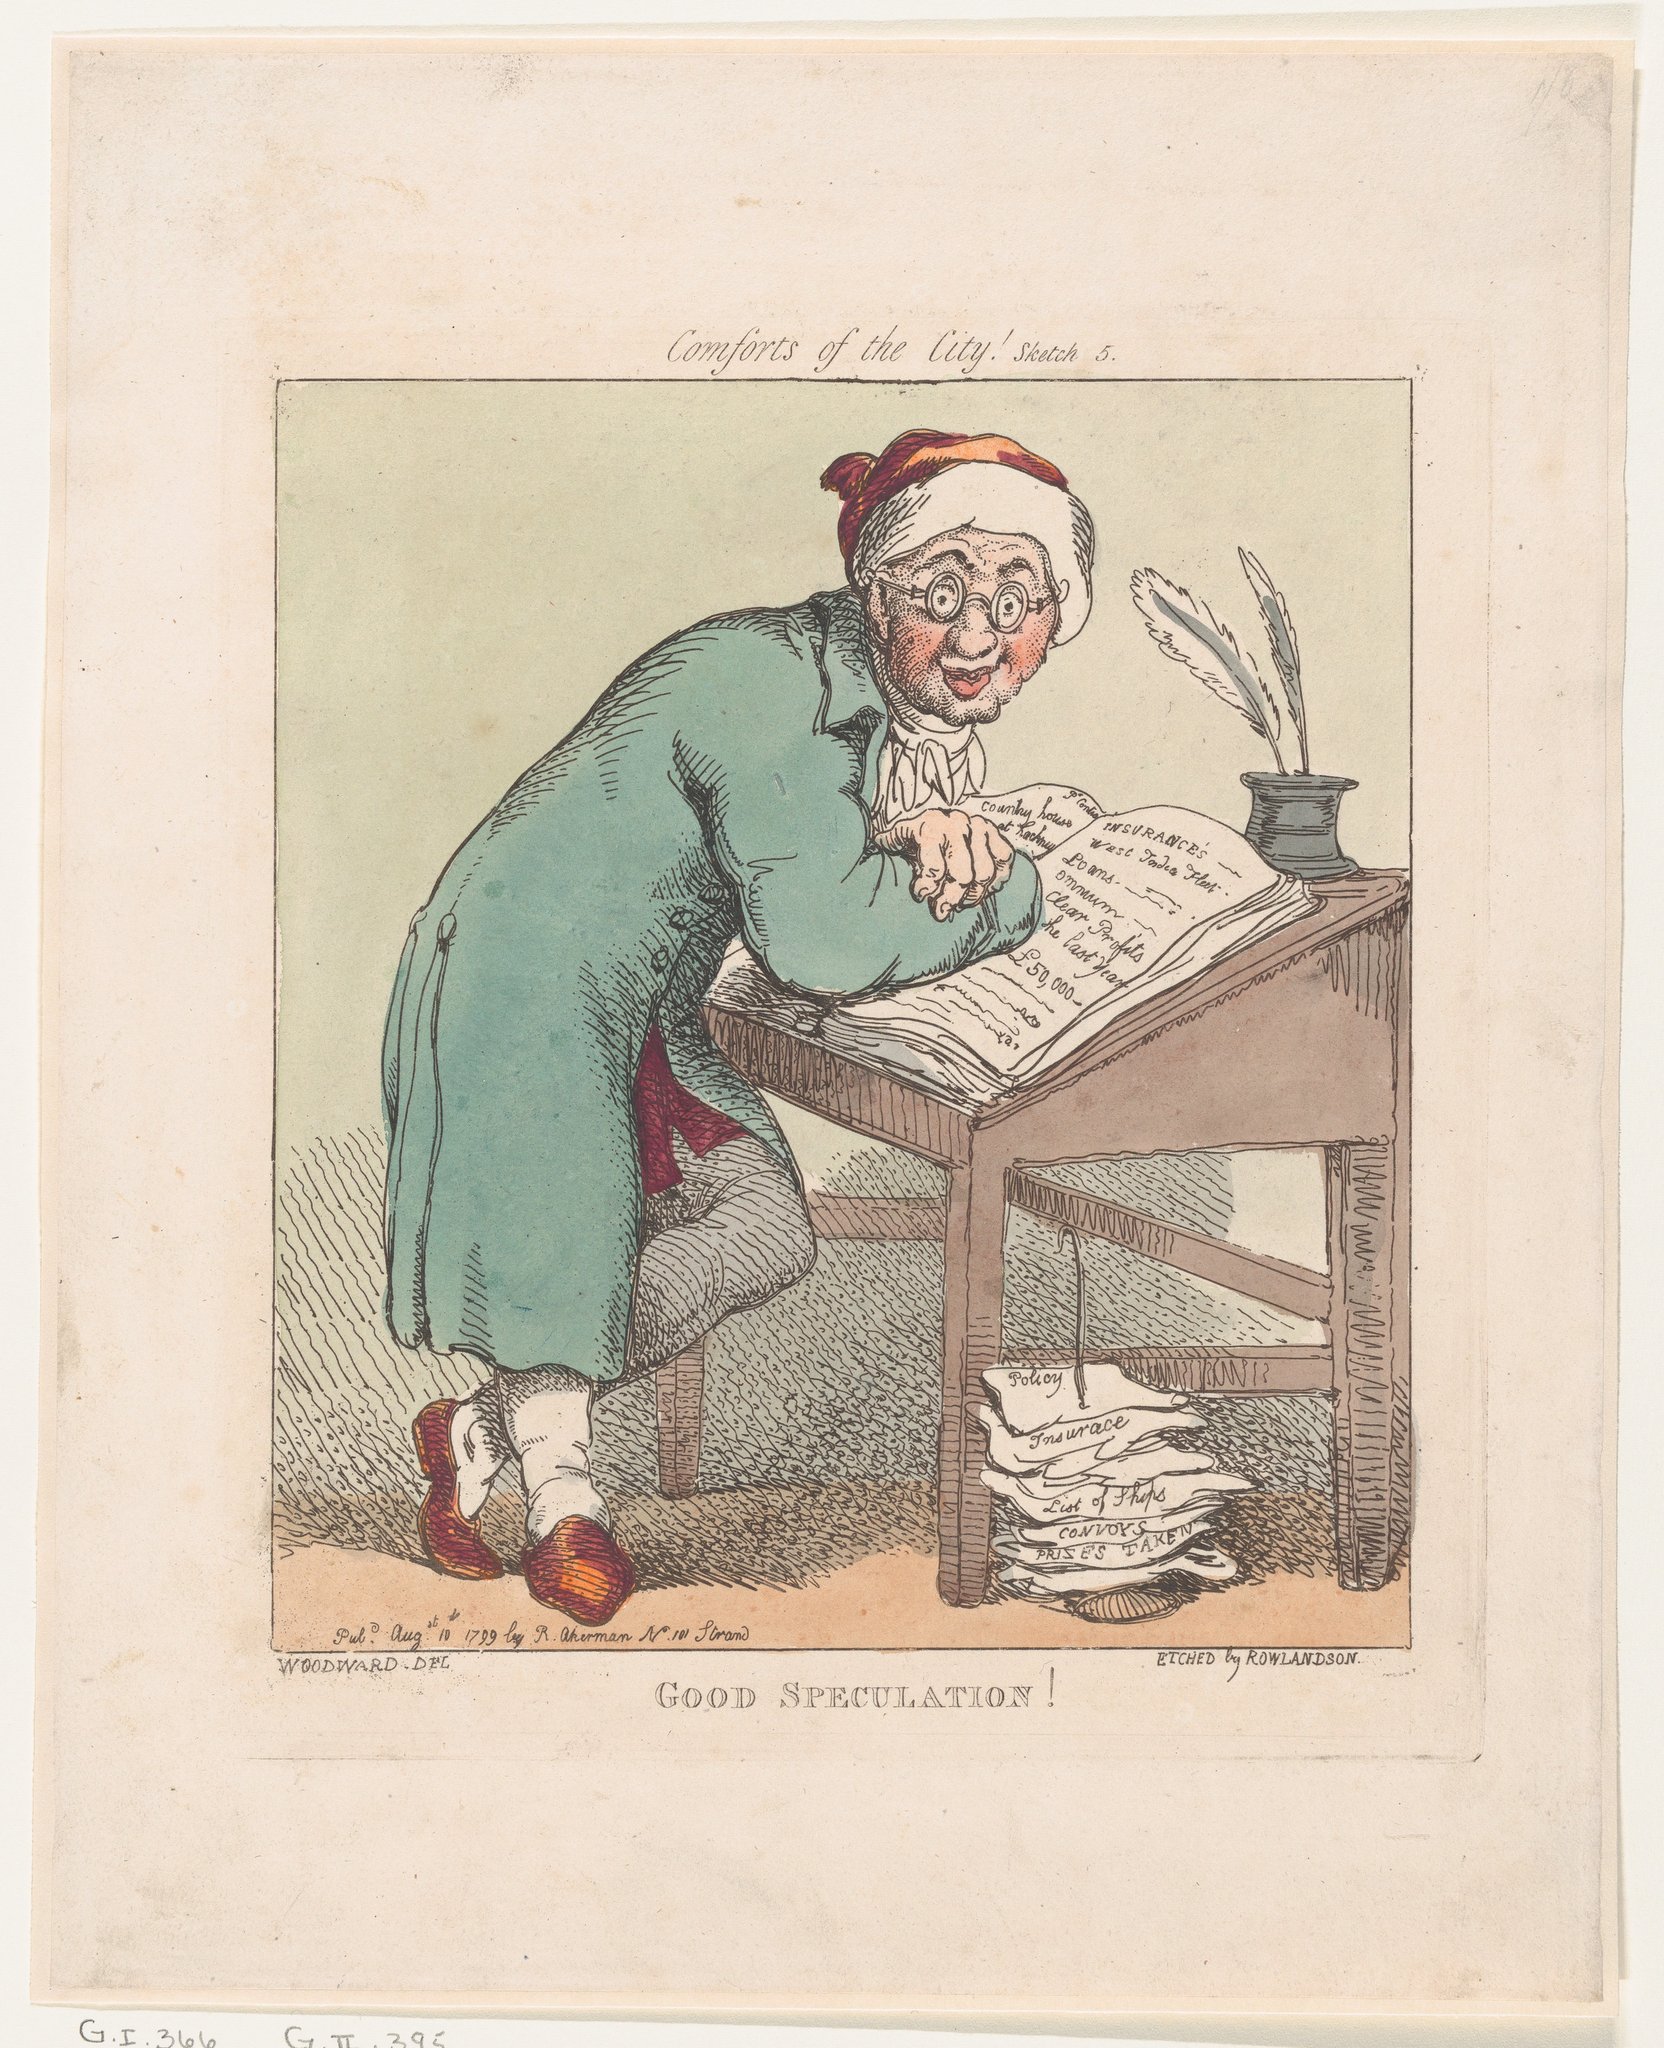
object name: print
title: Good Speculation!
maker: thomas rowlandson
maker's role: artist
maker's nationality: british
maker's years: 1757-1827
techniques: etching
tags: men